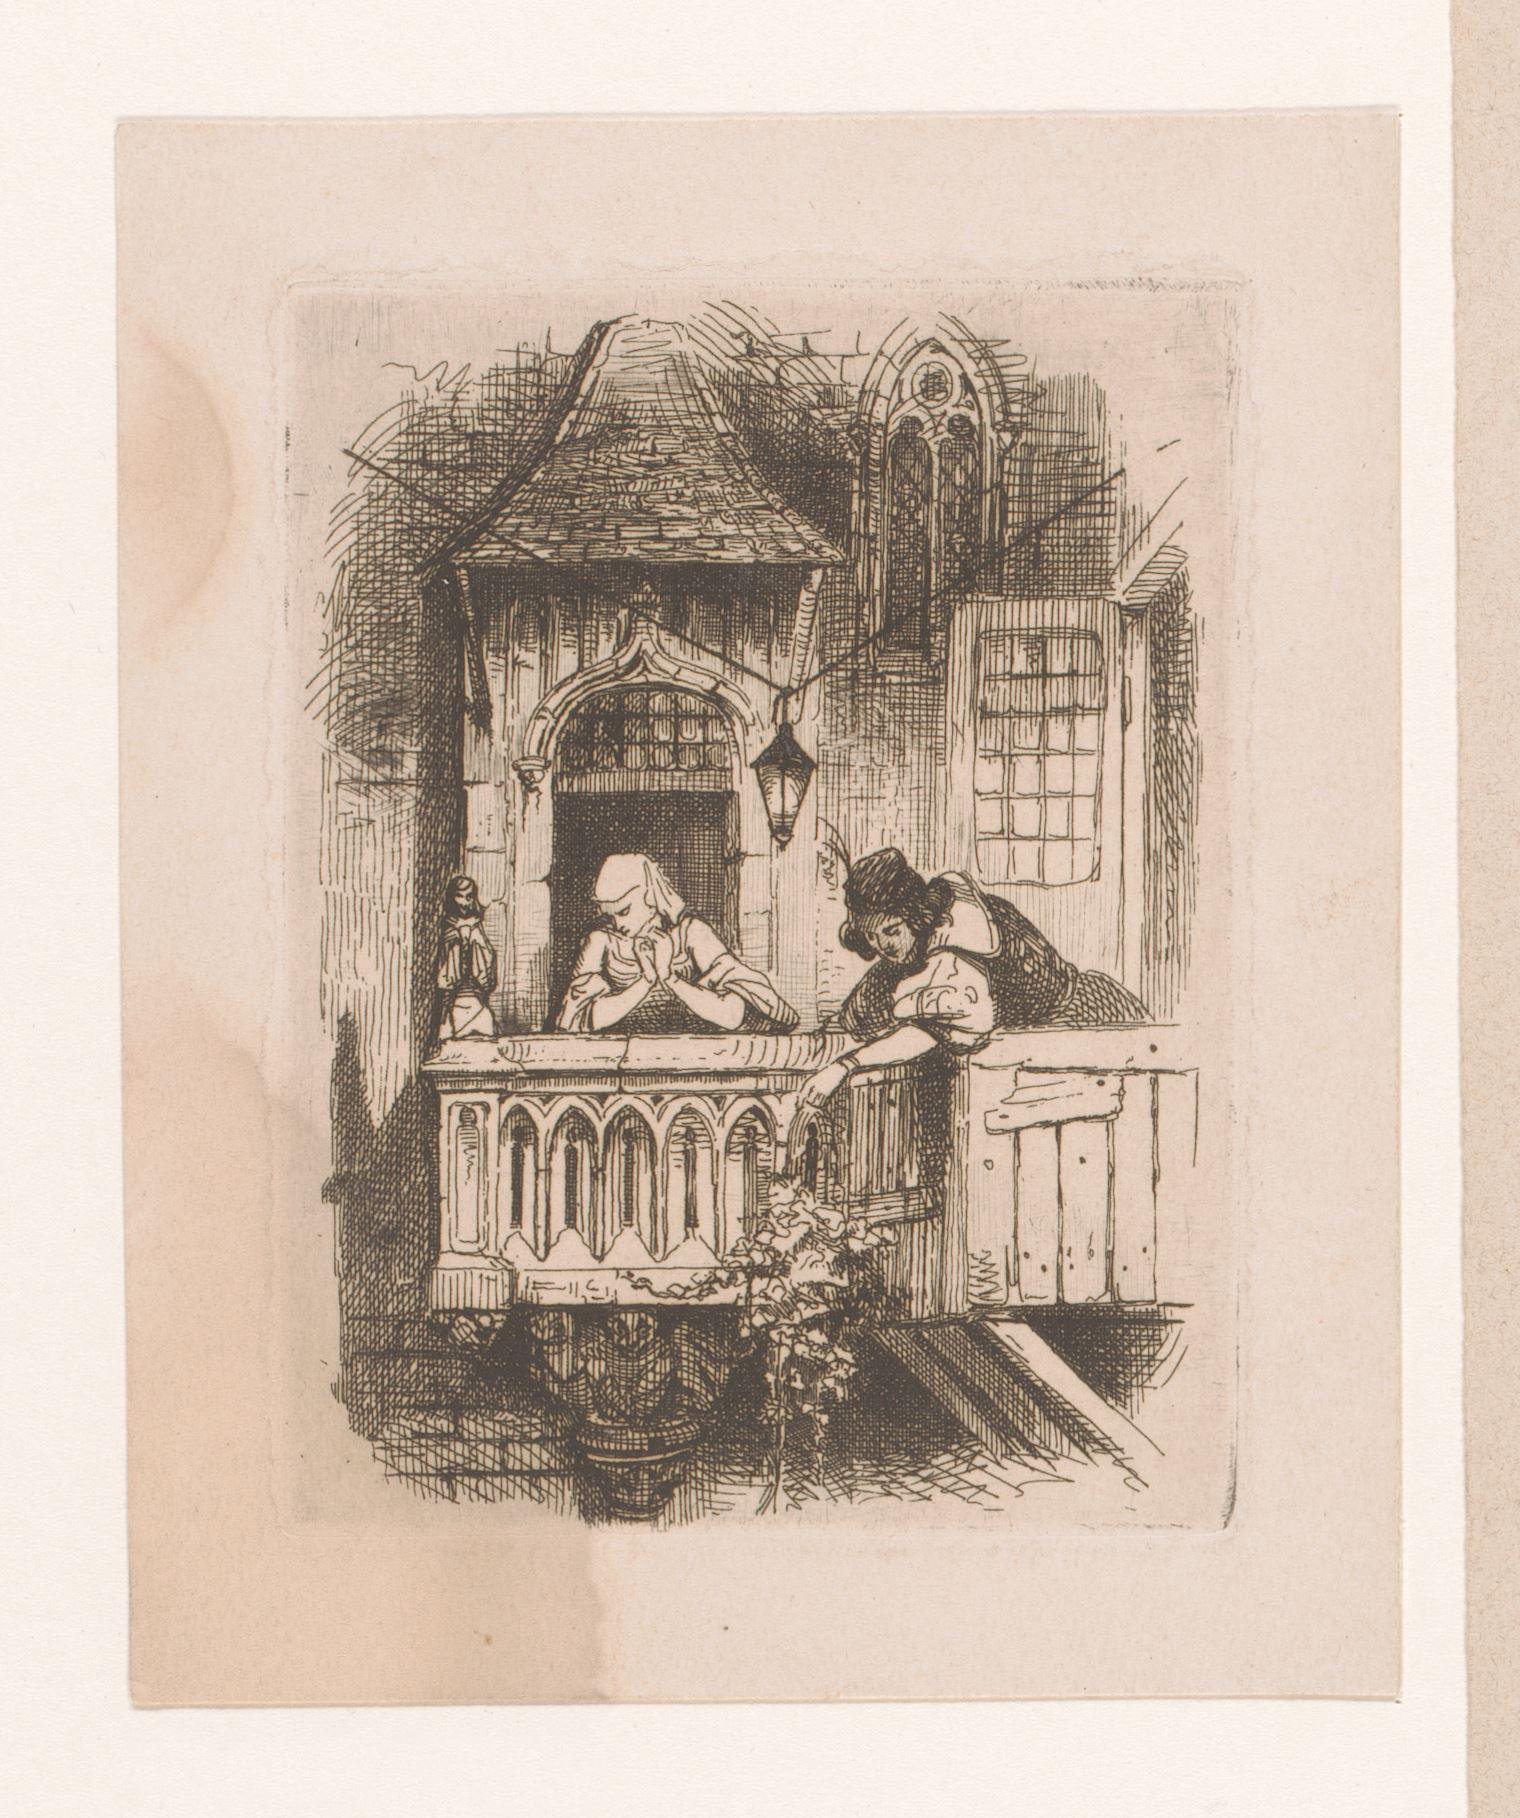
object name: print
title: Man en vrouw leunen over de rand van een balkon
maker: corneille seghers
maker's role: draughtsman, print maker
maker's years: 1814-1869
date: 1824-1869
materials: paper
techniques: drypoint, etching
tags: leaning forward, balcony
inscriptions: collector's mark: Lugt 2228